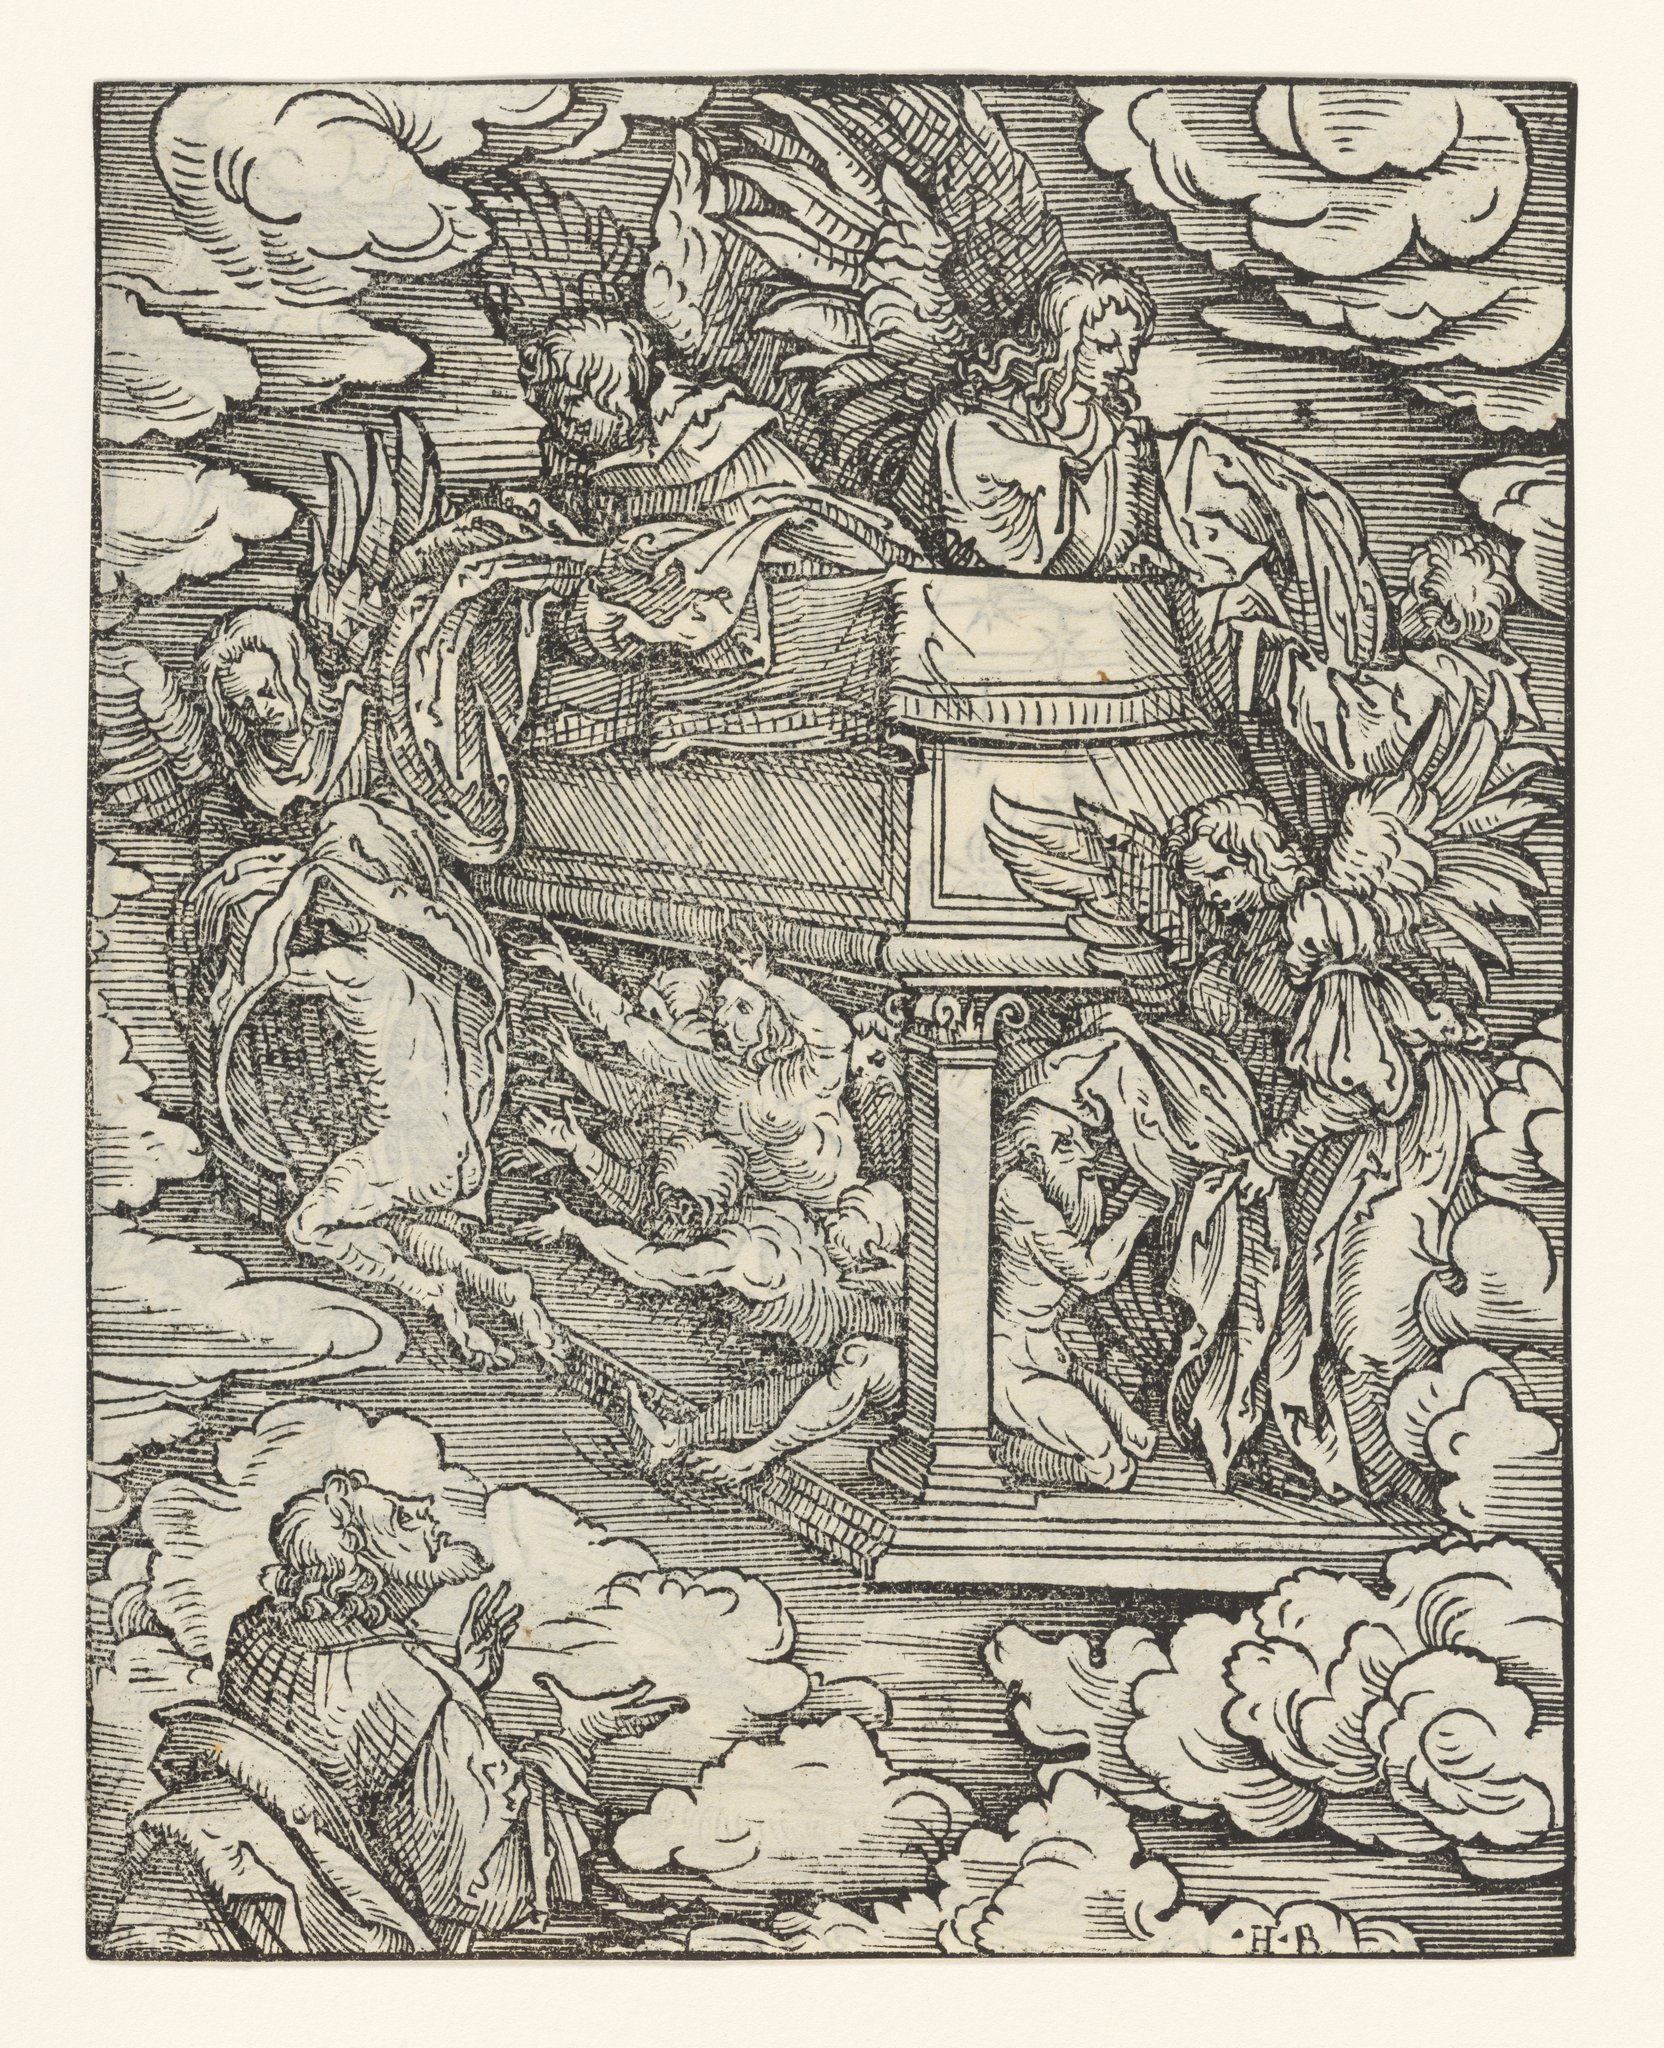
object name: print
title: The Clothing of the Elect, plate 4 from The Apocalypse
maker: hans burgkmair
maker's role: artist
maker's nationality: german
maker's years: 1473-1531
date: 1523-1524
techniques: woodcut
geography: germany